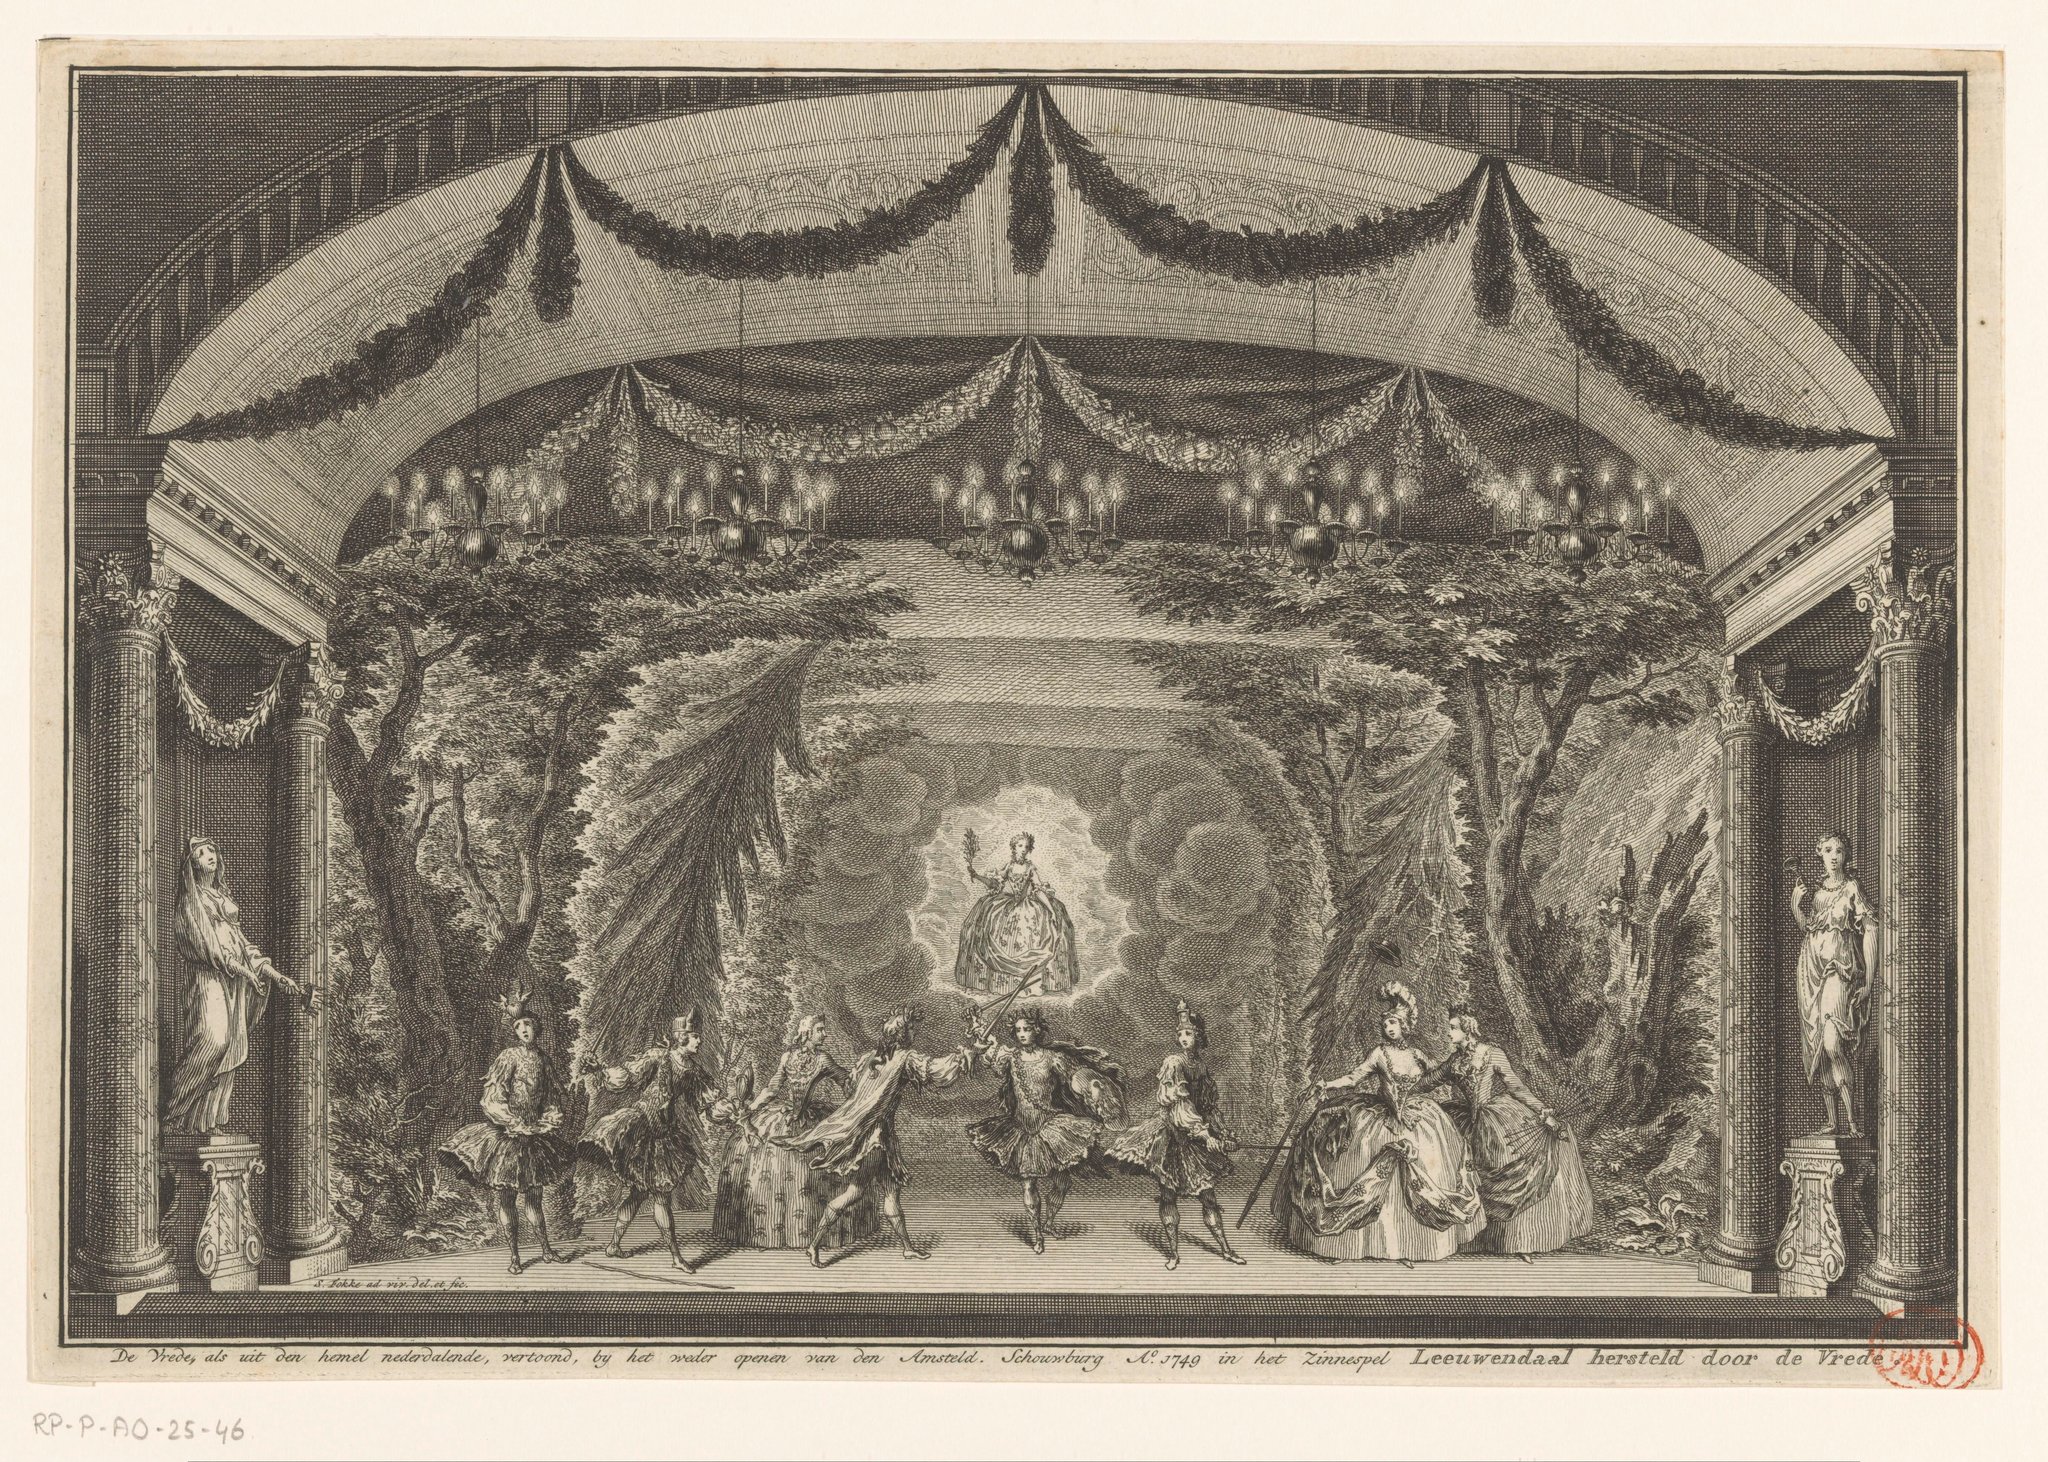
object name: print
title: Toneelopvoering bij de heropening van de schouwburg aan de Keizersgracht te Amsterdam, 1749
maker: simon fokke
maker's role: draughtsman, print maker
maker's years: 1712-1784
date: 1749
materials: paper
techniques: engraving, etching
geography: amsterdam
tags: group of actors, troupe; actors on the stage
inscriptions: collector's mark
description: Toneelopvoering van het toneelstuk van Lucas Pater getiteld 'Leeuwendaal hersteld door de Vrede' bij de heropening van de Amsterdamse Schouwburg aan de Keizersgracht op 28 juli 1749. De schouwburg was sinds 1747 gesloten.